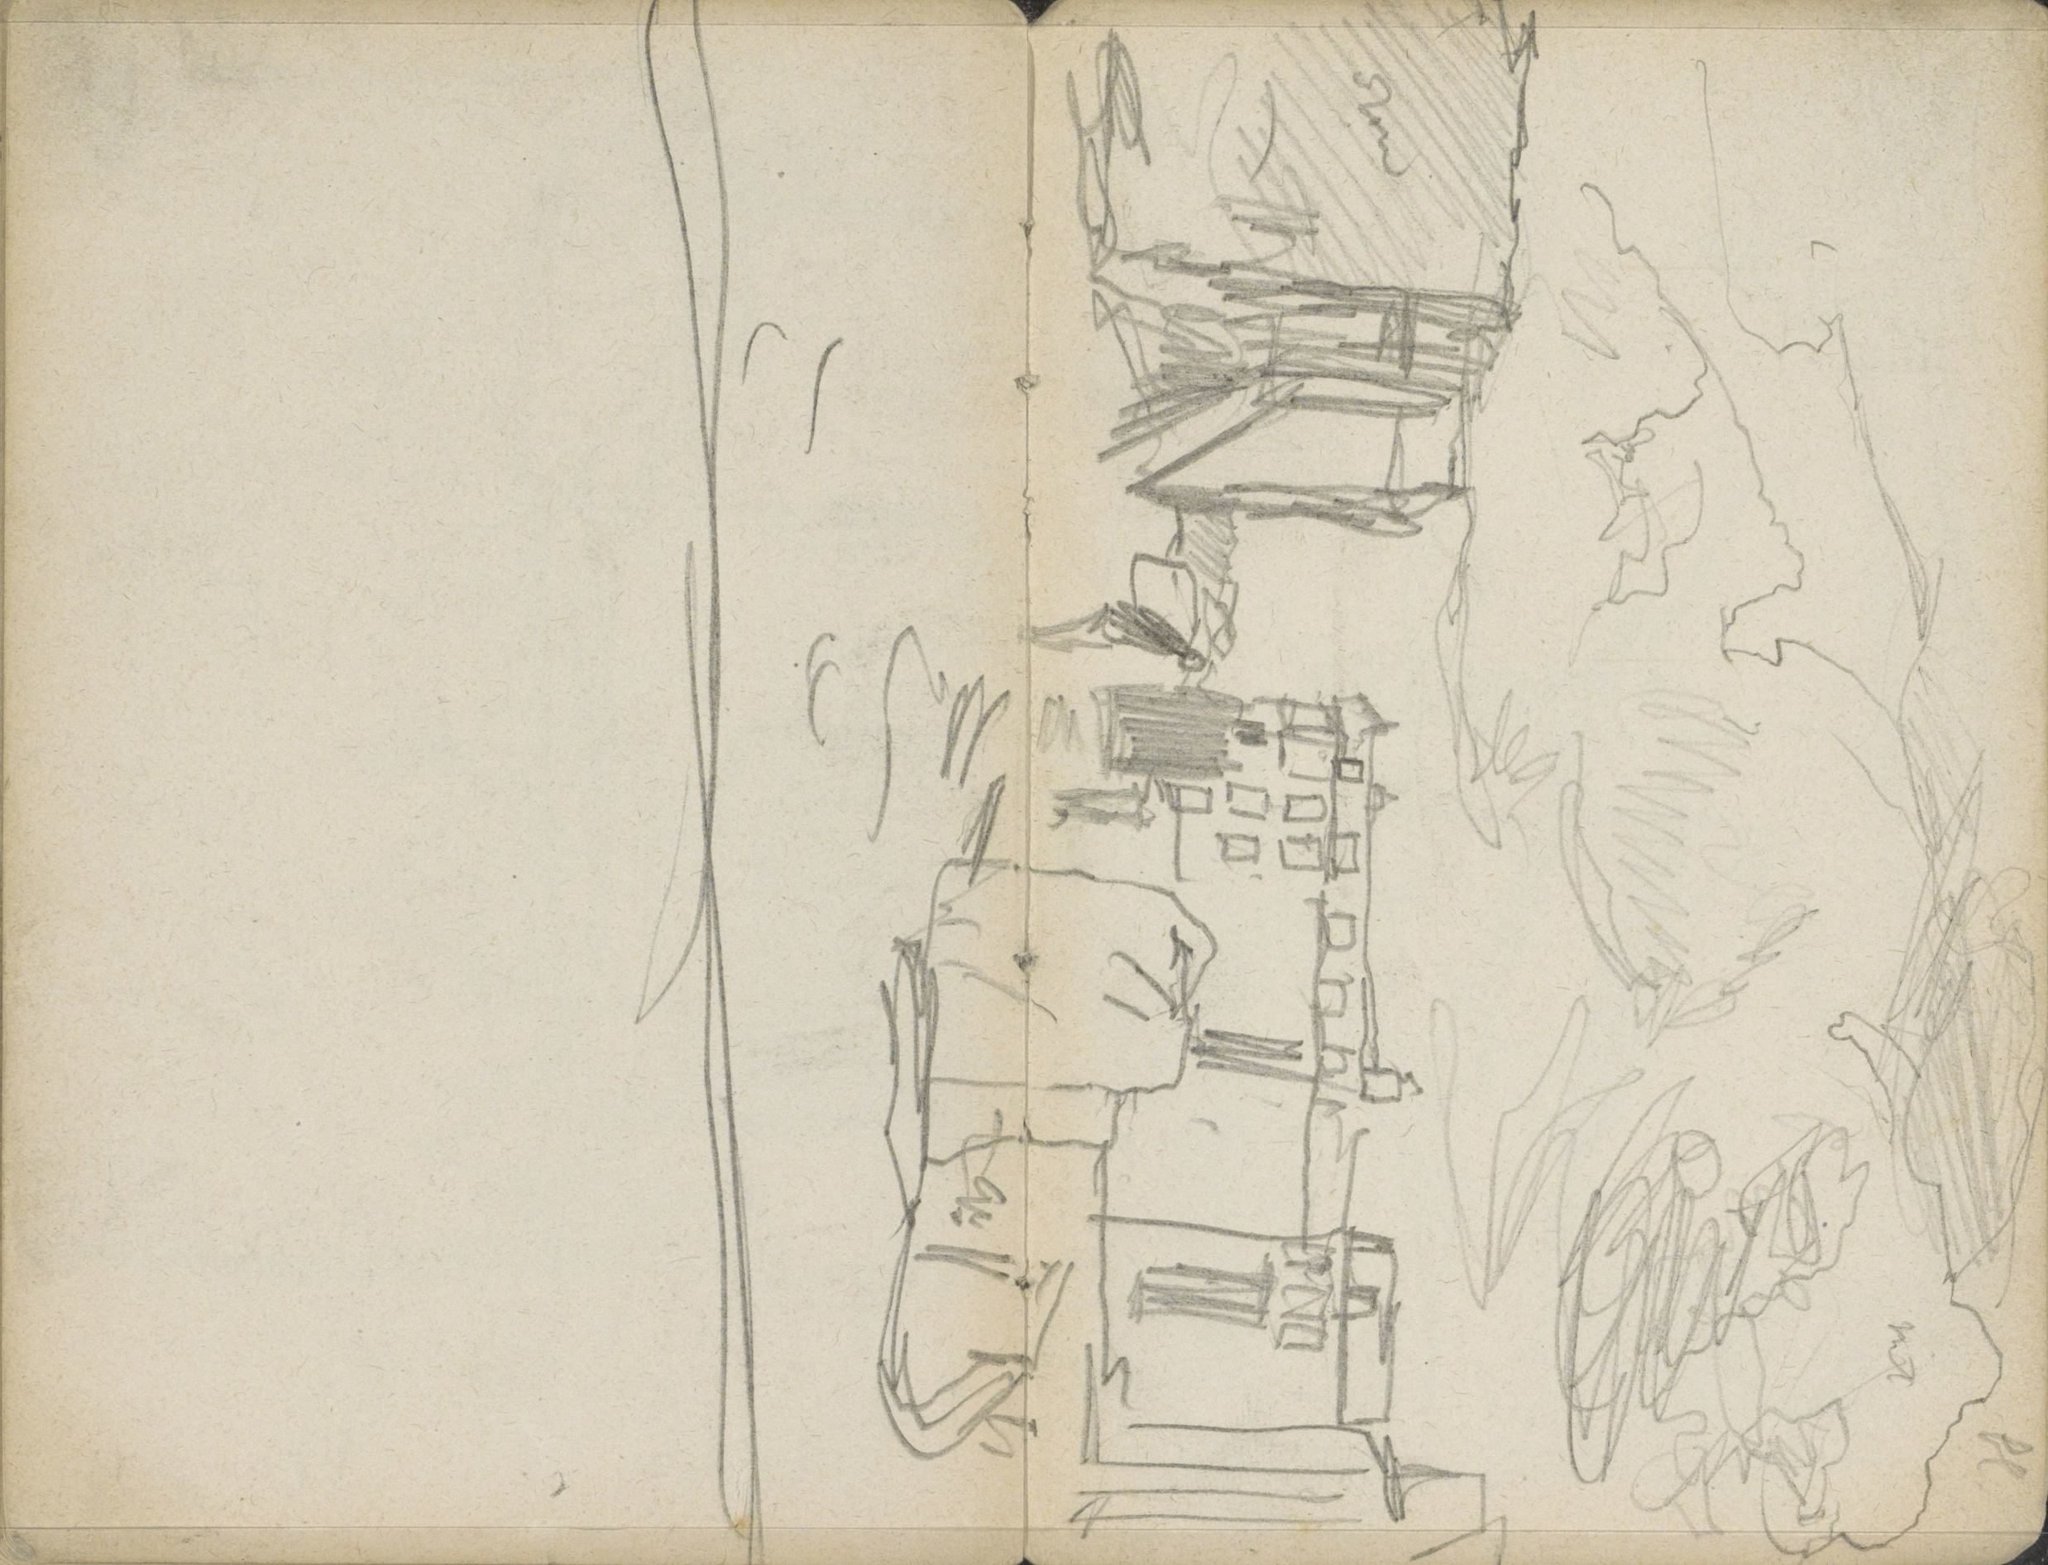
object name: sketchbook leaf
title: Gezicht in de Van Lennepbuurt te Amsterdam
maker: george hendrik breitner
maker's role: draughtsman, painter, print maker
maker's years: 1857-1923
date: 1900-1901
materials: paper, pencil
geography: amsterdam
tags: urban housing, street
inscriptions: kleurnotitie, handgeschreven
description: Gezicht in de Van Lennepbuurt te Amsterdam. Pagina 85 en pagina 86 uit een schetsboek met 46 bladen vervaardigd te Amsterdam.